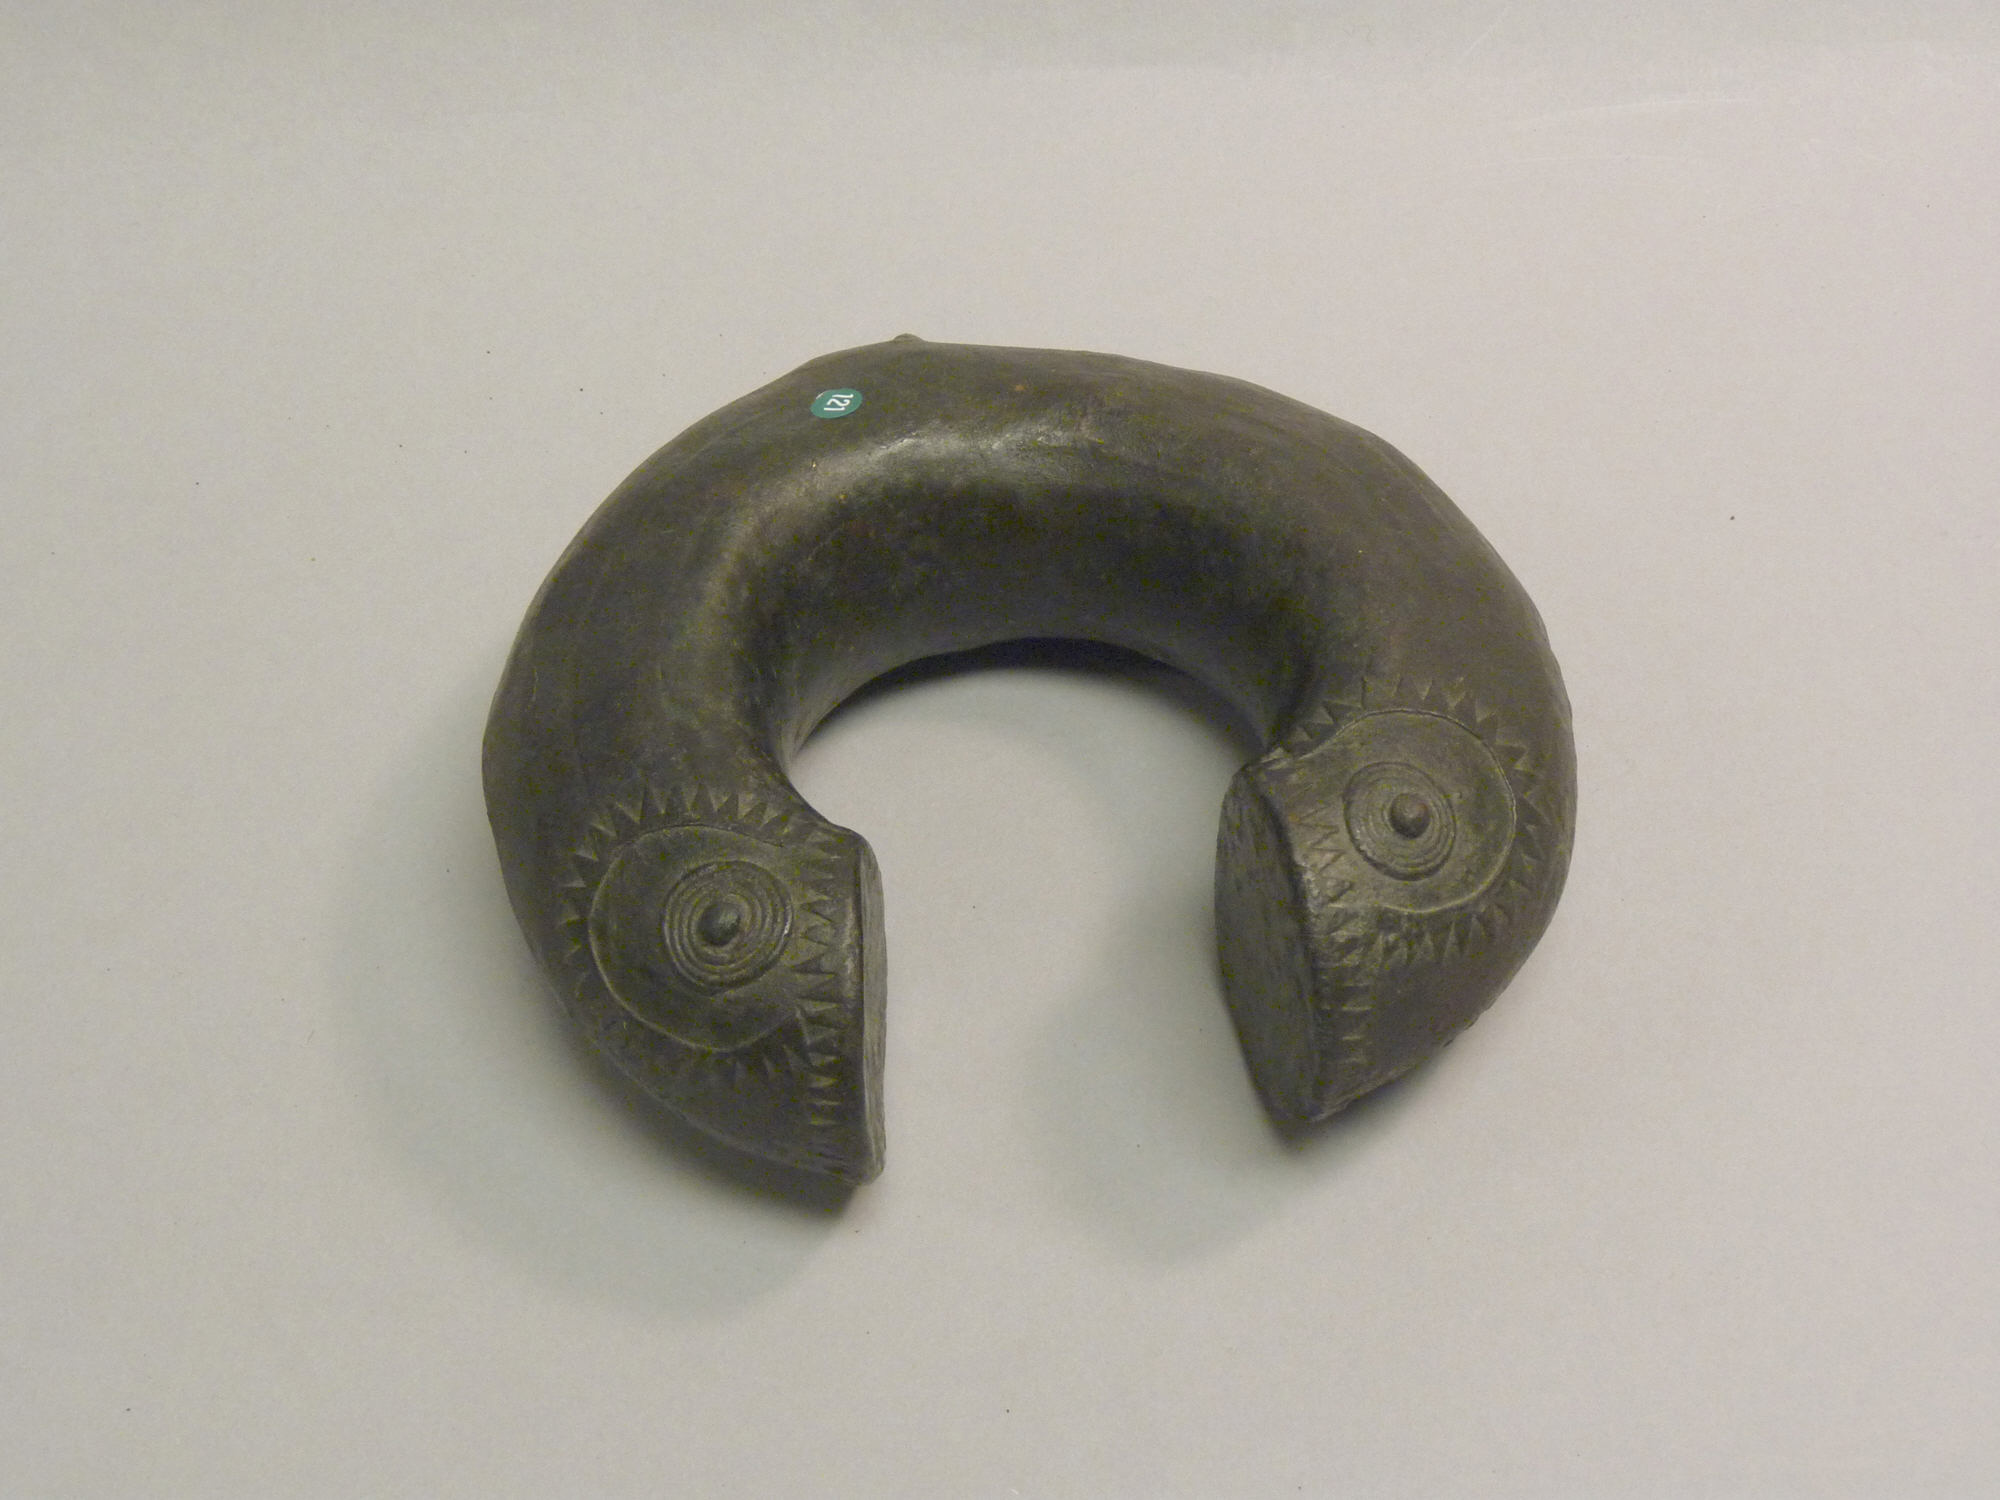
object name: anklet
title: Wide Anklet with Chevrons Surrounding Bosses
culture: thai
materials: bronze